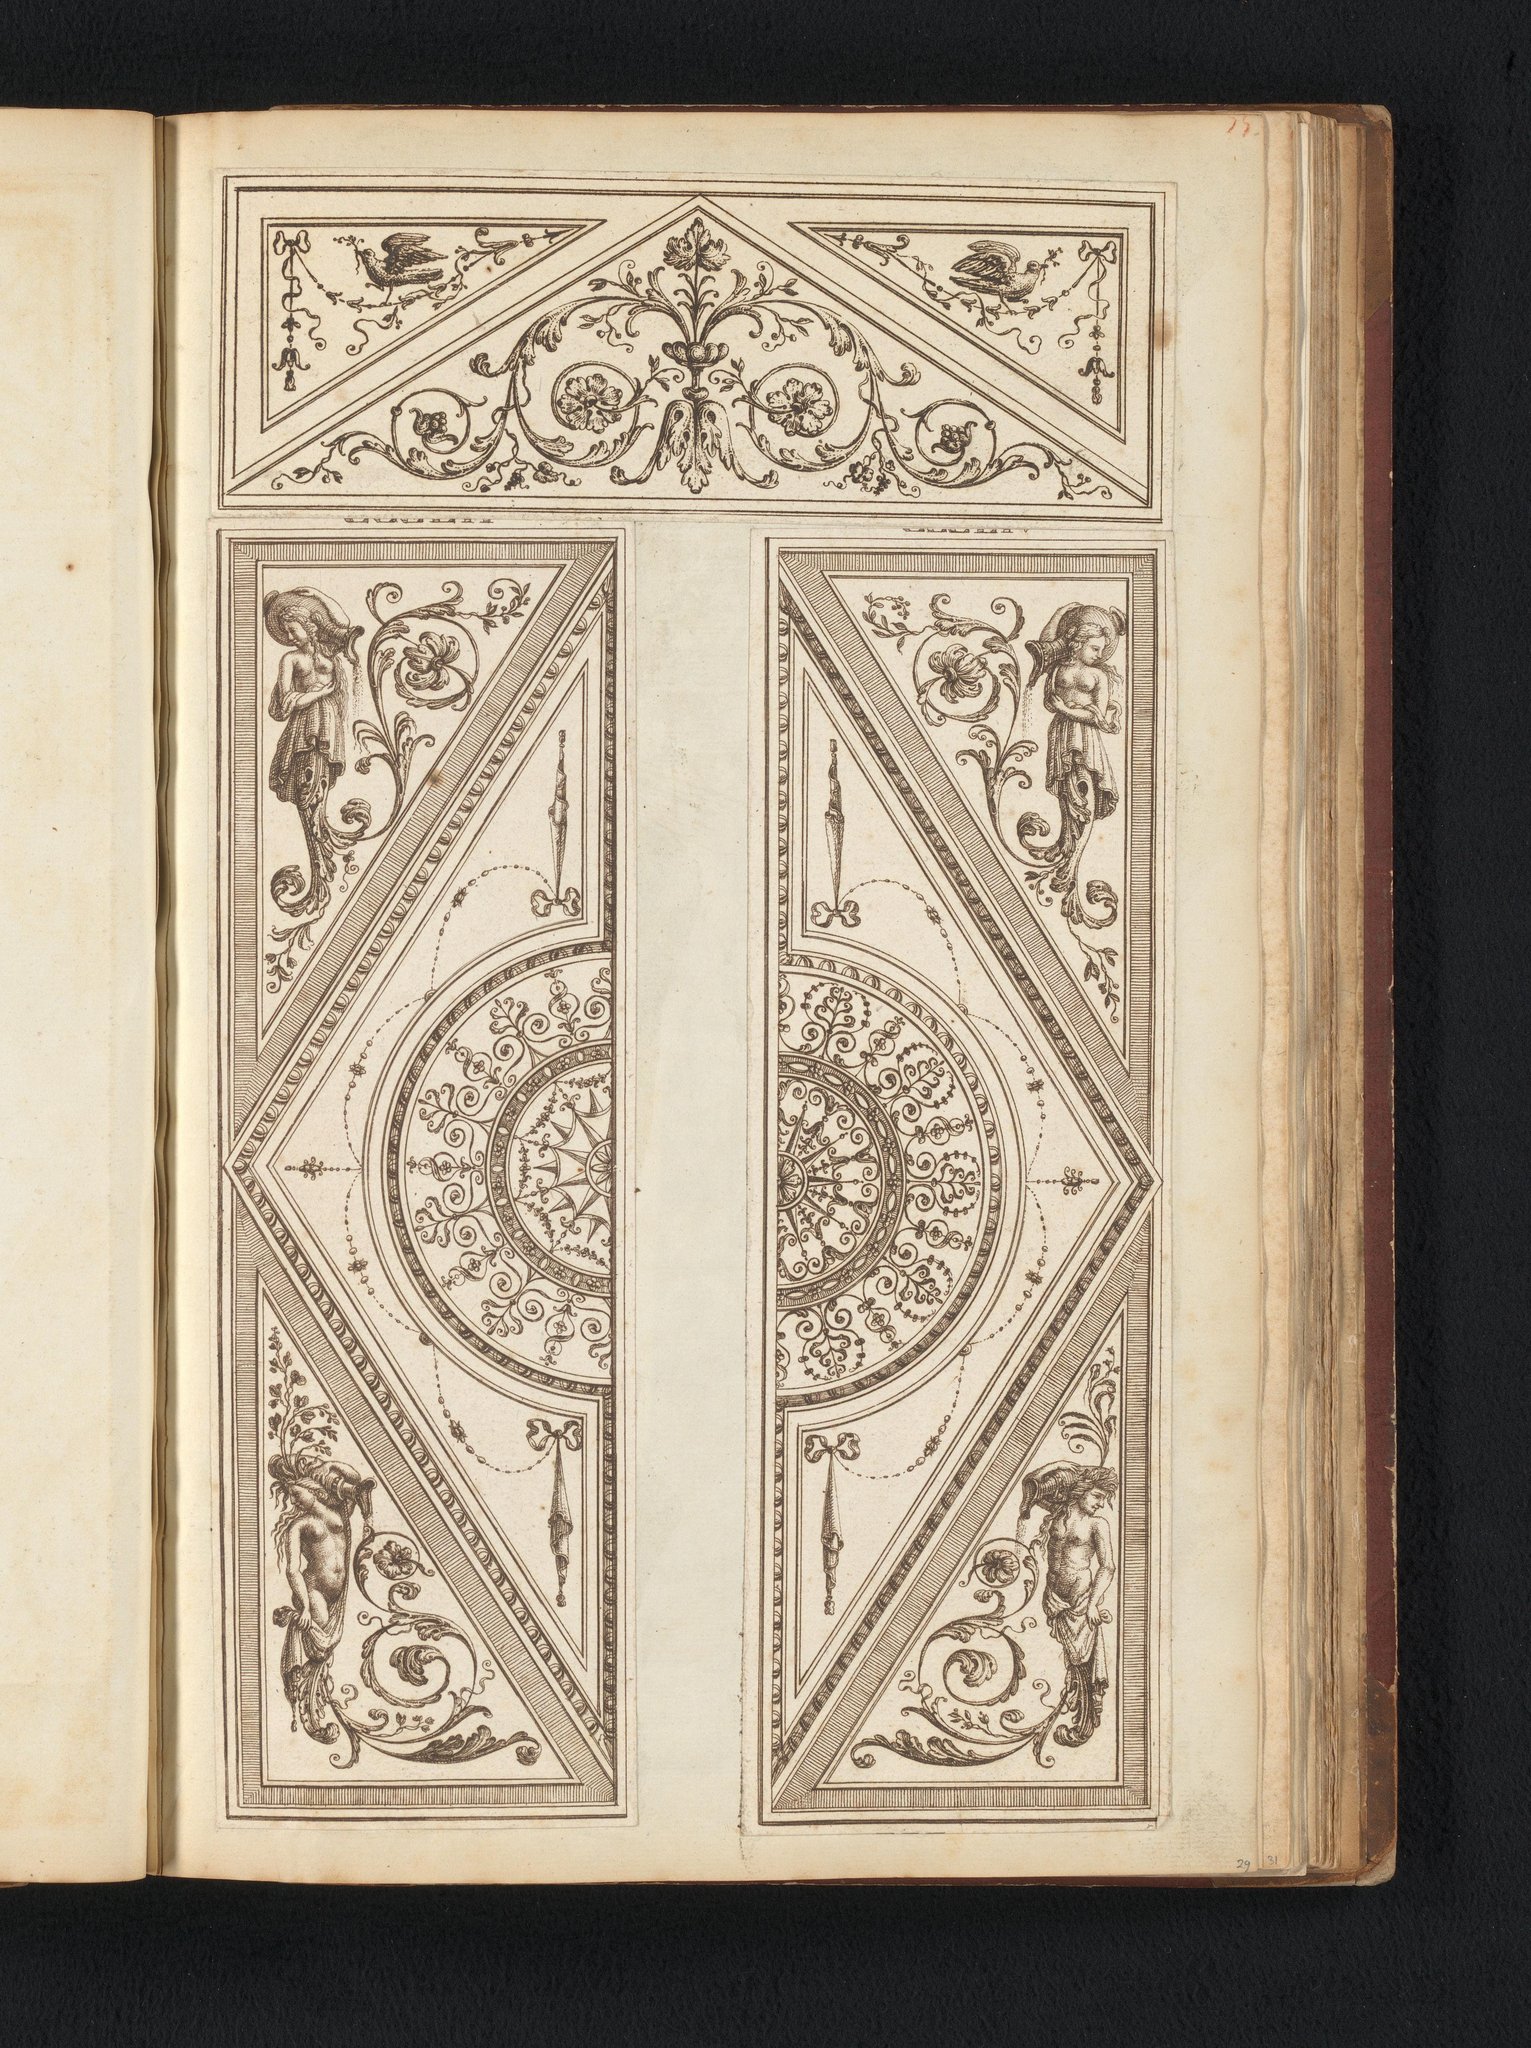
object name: album leaf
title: Drie friezen met ornamenten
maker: Anonymous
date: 1750-1816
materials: paper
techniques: etching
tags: ornament ~ hybrid beings; human and animal forms mixed, ornament ~ arabesque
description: Drie friezen met ornamenten. Onderdeel van het tweede van twee albums met ingeplakte prenten en tekeningen te dienen als tekenvoorbeelden.